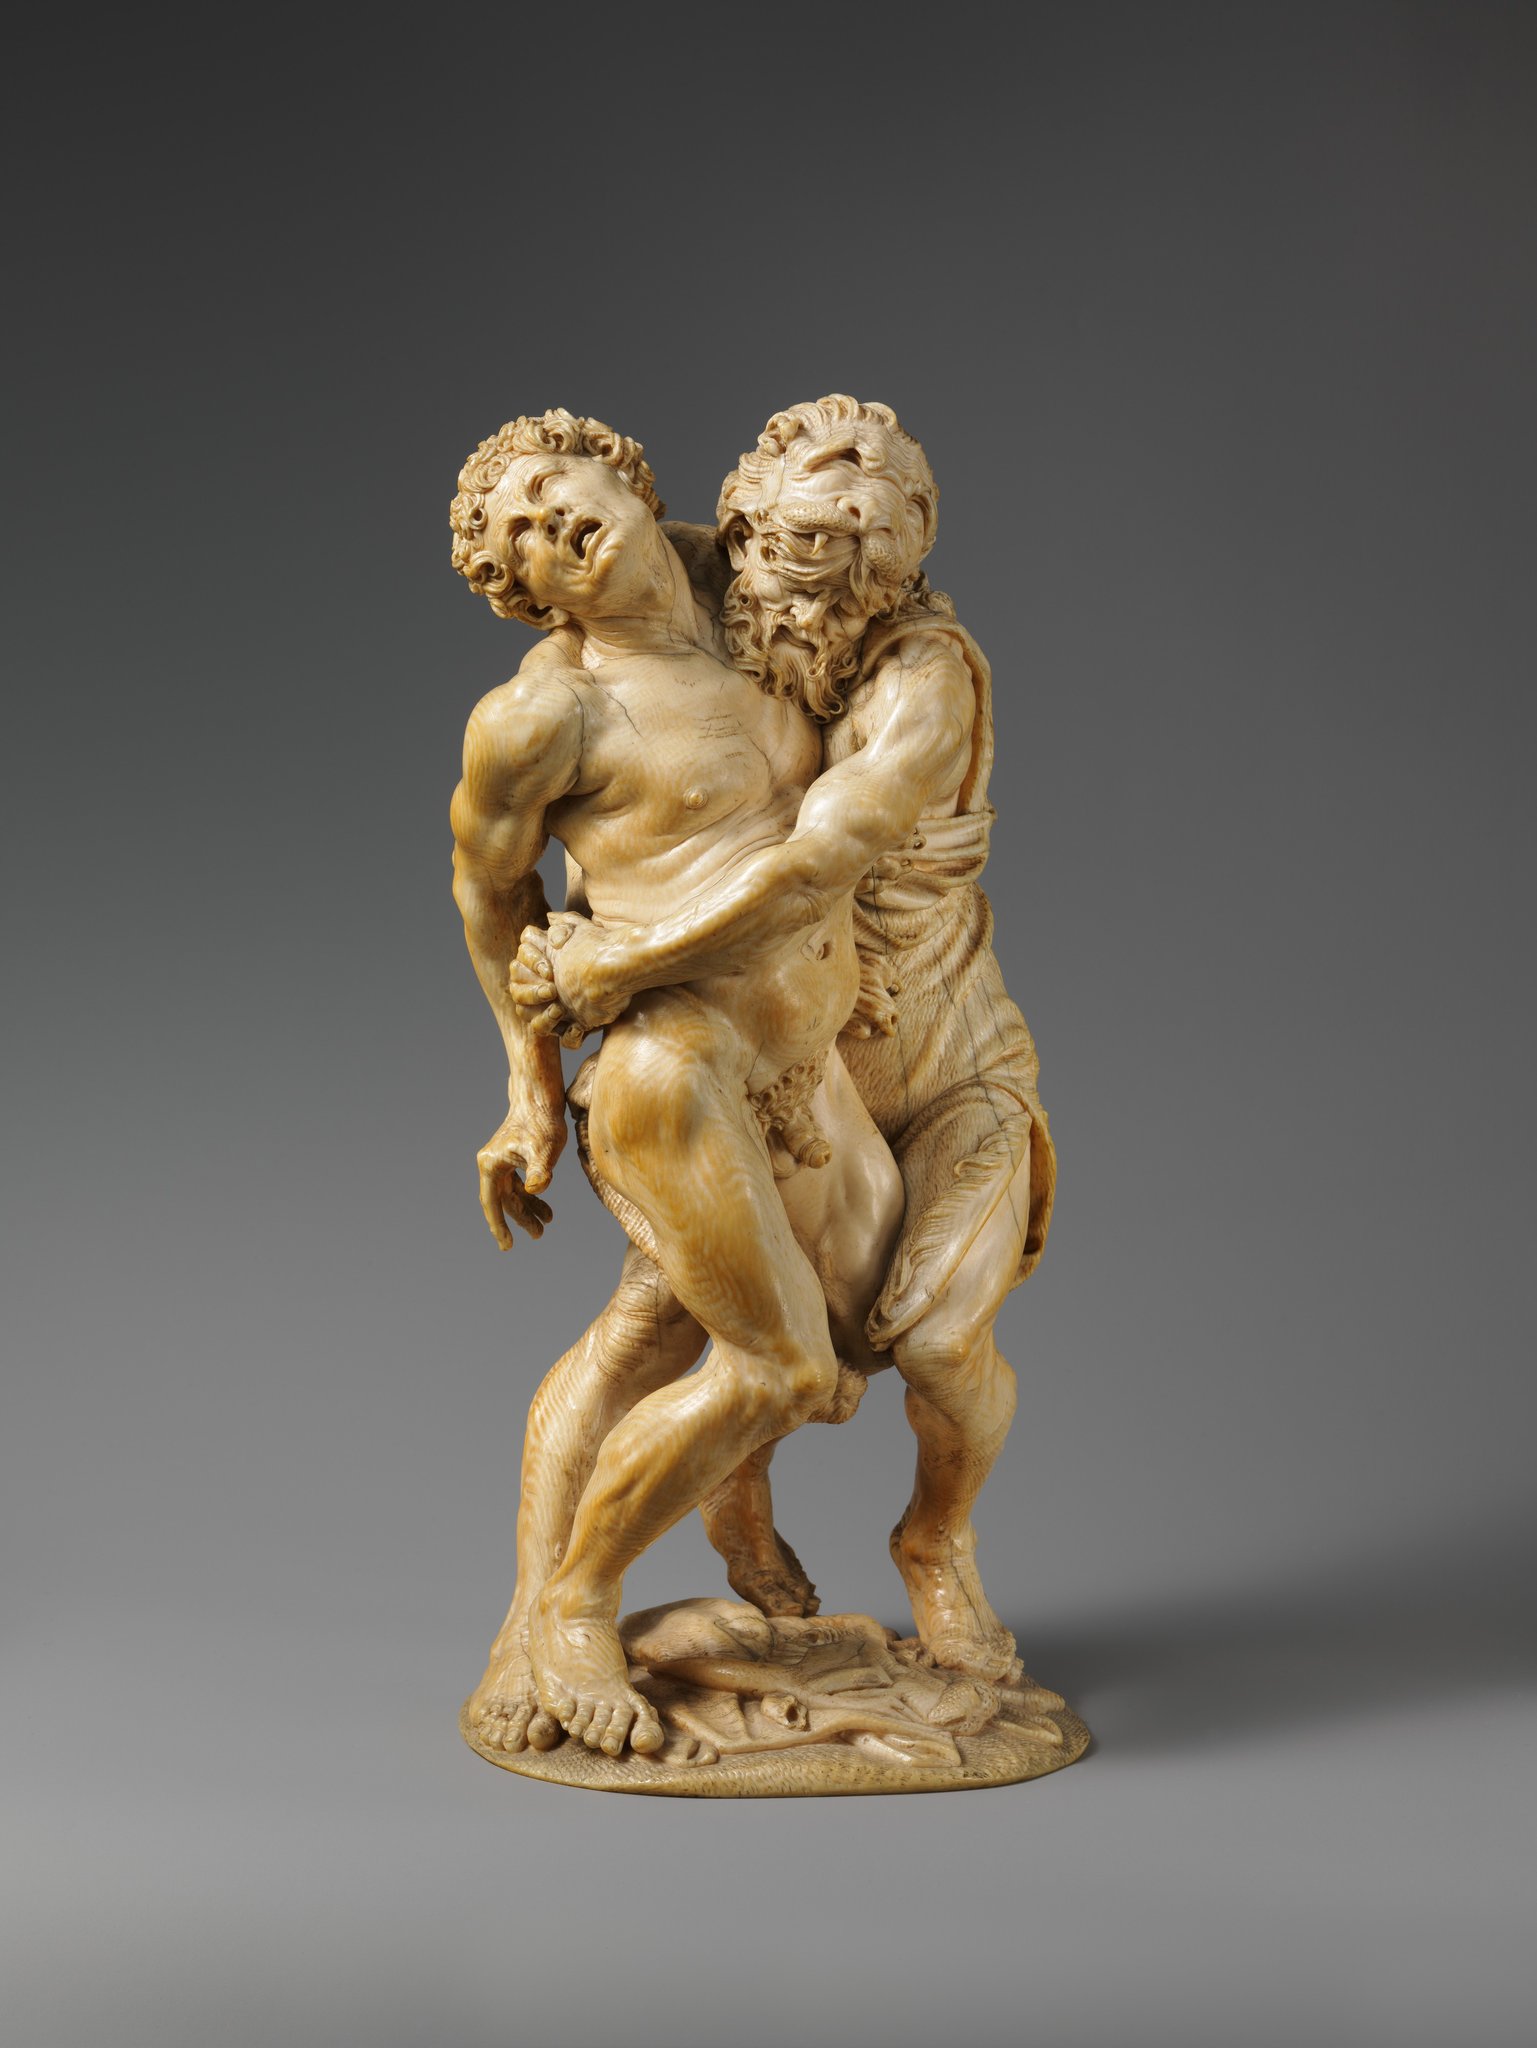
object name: statuette group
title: Hercules and Achelous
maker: master of the martyrdom of st. sebastian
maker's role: artist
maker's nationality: austrian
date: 1634-1666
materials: ivory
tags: male nudes,hercules